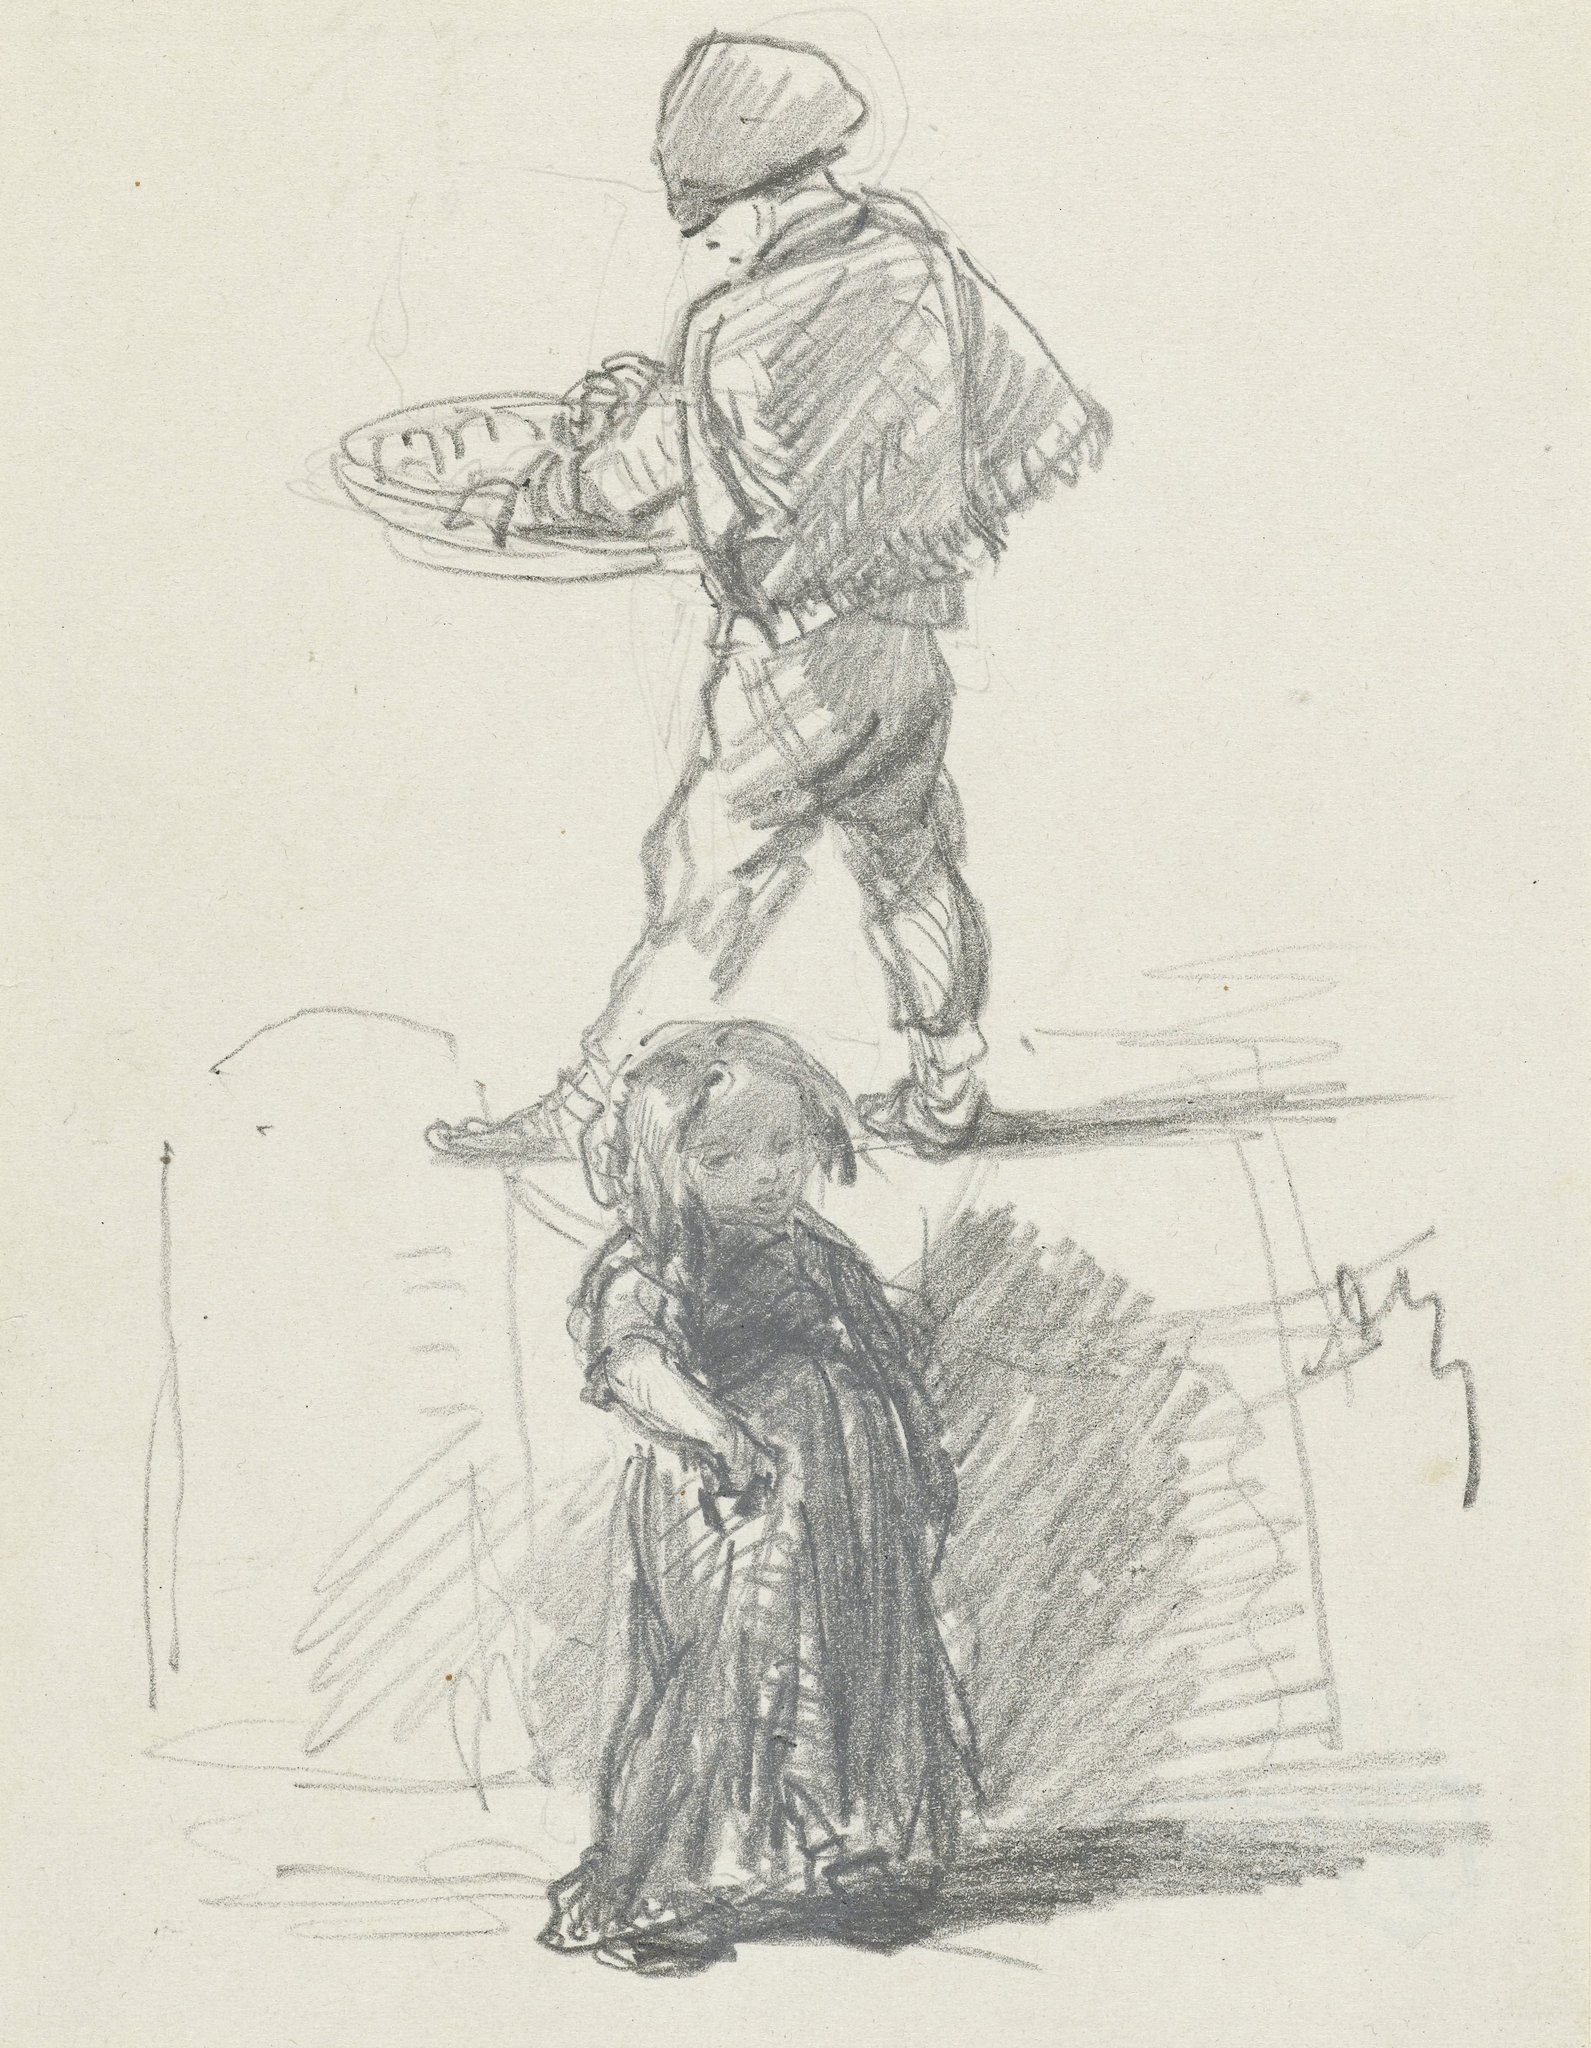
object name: drawing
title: Studiebeeldjes van een jongen met een mand en een meisje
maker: adolphe mouilleron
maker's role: draughtsman, print maker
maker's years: 1820-1881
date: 1830-1881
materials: paper, pencil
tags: boy (child between toddler and youth), girl (child between toddler and youth)